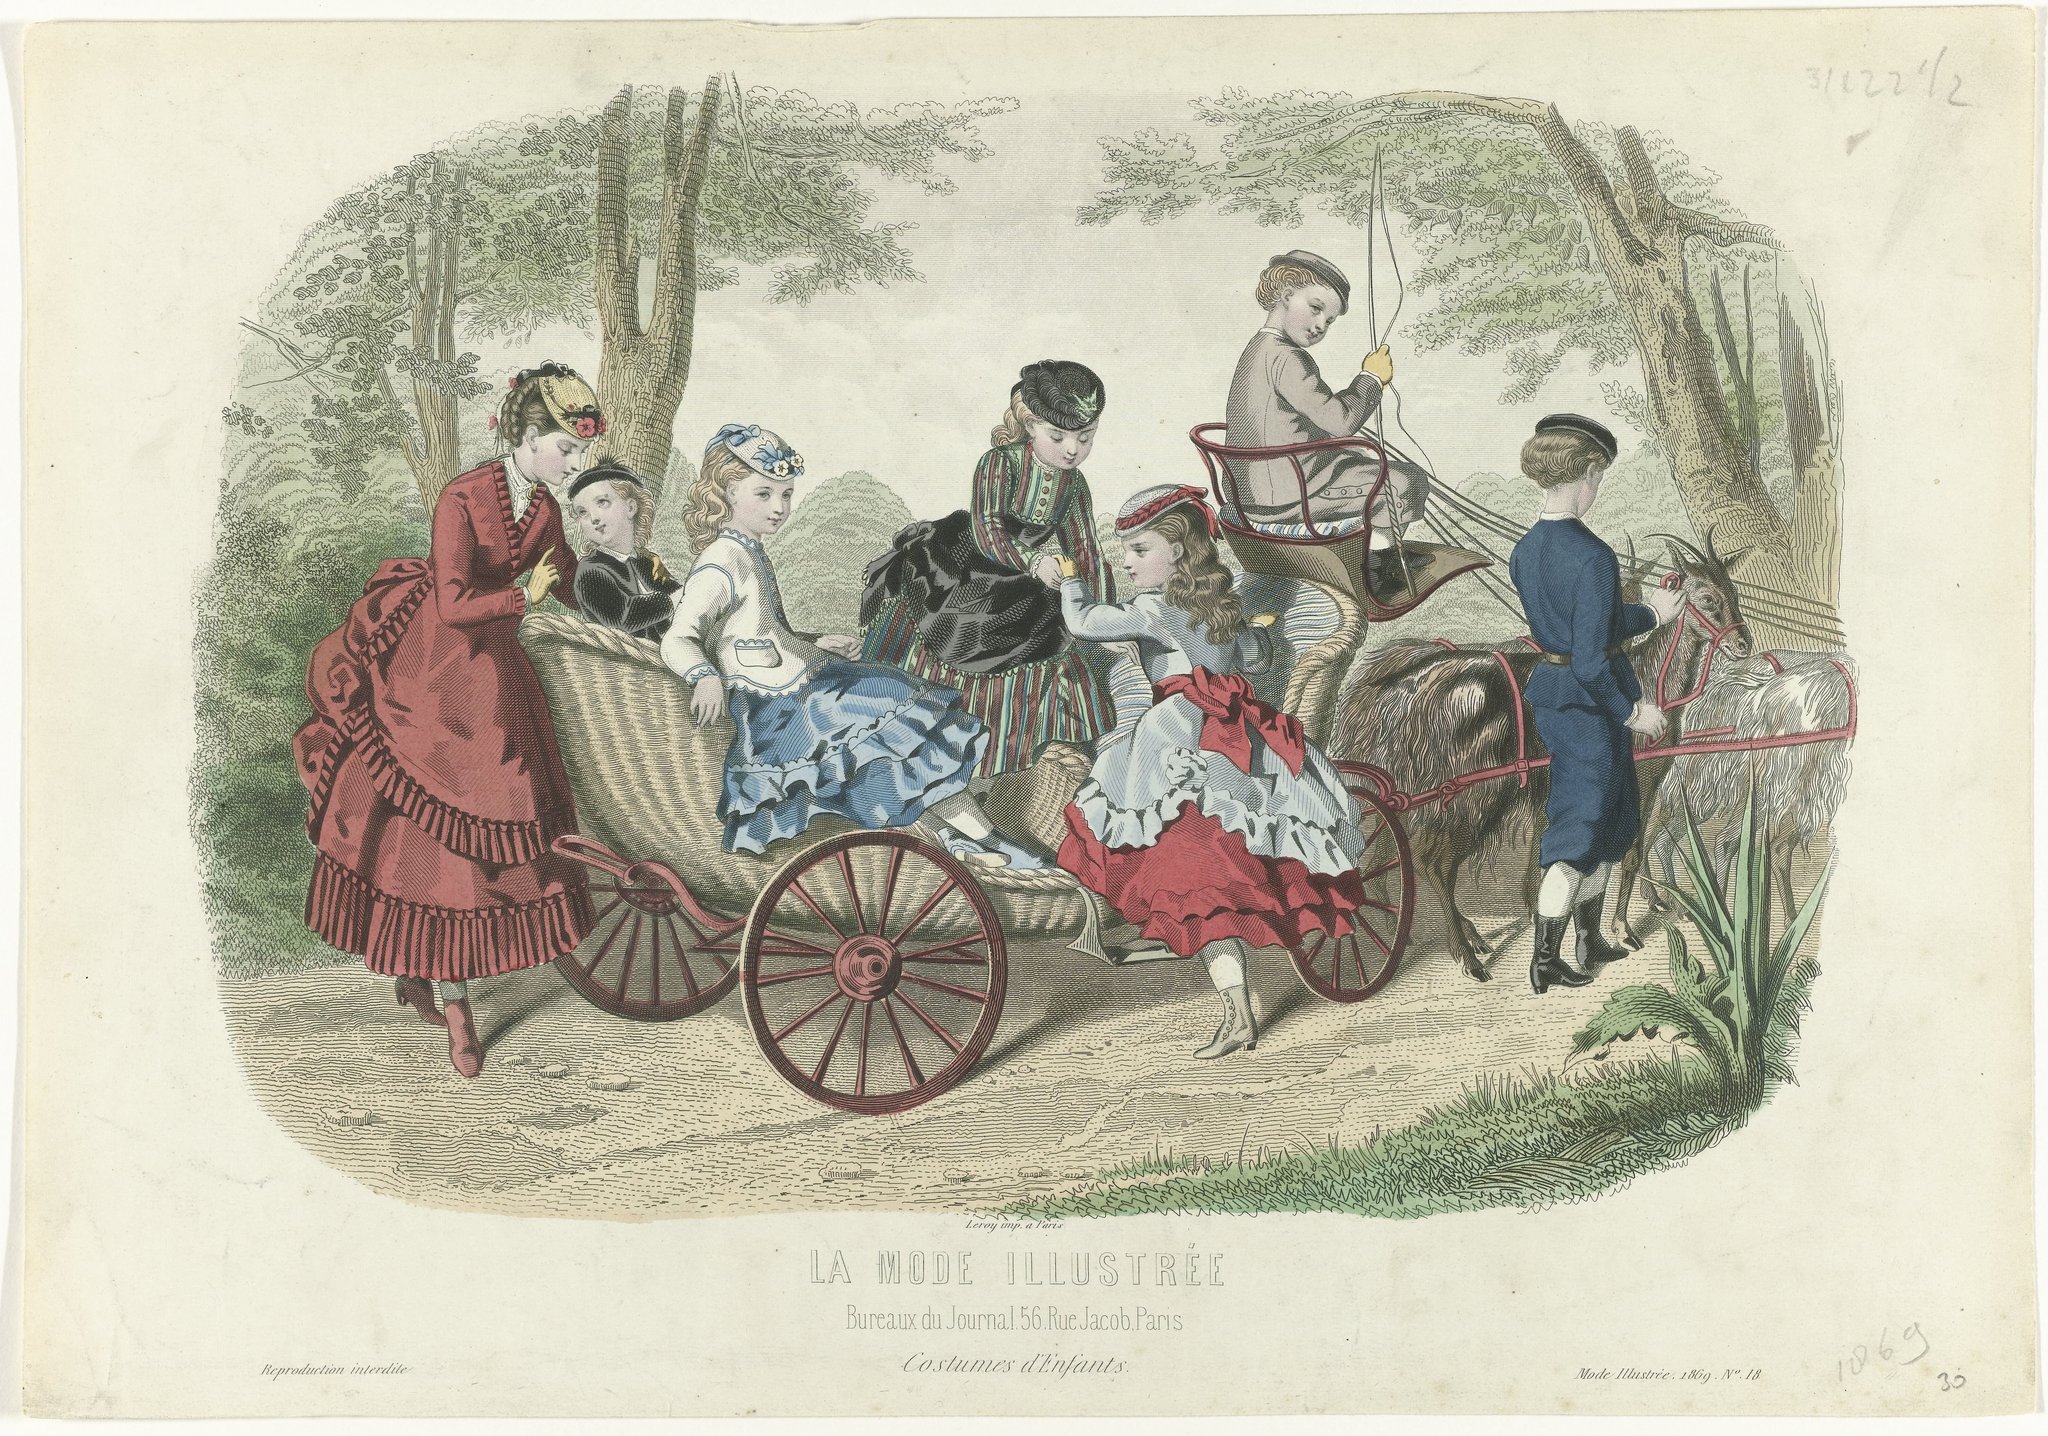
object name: fashion print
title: La Mode Illustrée, 1869, No. 18 : Costumes d'Enfants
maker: huard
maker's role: print maker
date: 1869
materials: paper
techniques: engraving, hand coloring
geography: paris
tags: skirt (+ girls' clothes), trousers, breeches, etc. (breeches) (+ boys' clothes), head-gear: hat (+ girls' clothes), clothing for the upper part of the body (+ boys' clothes), boots (+ girls' clothes), fashion plates, four-wheeled vehicle drawn by more than three animals, dress, gown (+ girls' clothes), whip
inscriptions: address: ‘BUREAUX DU JOURNAL, 56, RUE JACOB_PARIS’, caption: ‘Costumes d'Enfants’, title: ‘LA MODE ILLUSTRÉE’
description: Kinderkleding. Een groep kinderen in en rondom een bokkenwagen. Een meisje helpt een ander meisje met in de wagen te stappen. Op de koetsiersbank zit een jongen met zweep. Deze afbeelding is afgedrukt met twee verschillende platen. Er zijn kleine verschillen te zien bij de bosjes achter het staande meisje in de kar en achter het meisje in de rode japon. Prent uit het modetijdschrift La Mode Illustrée (1860-1937).